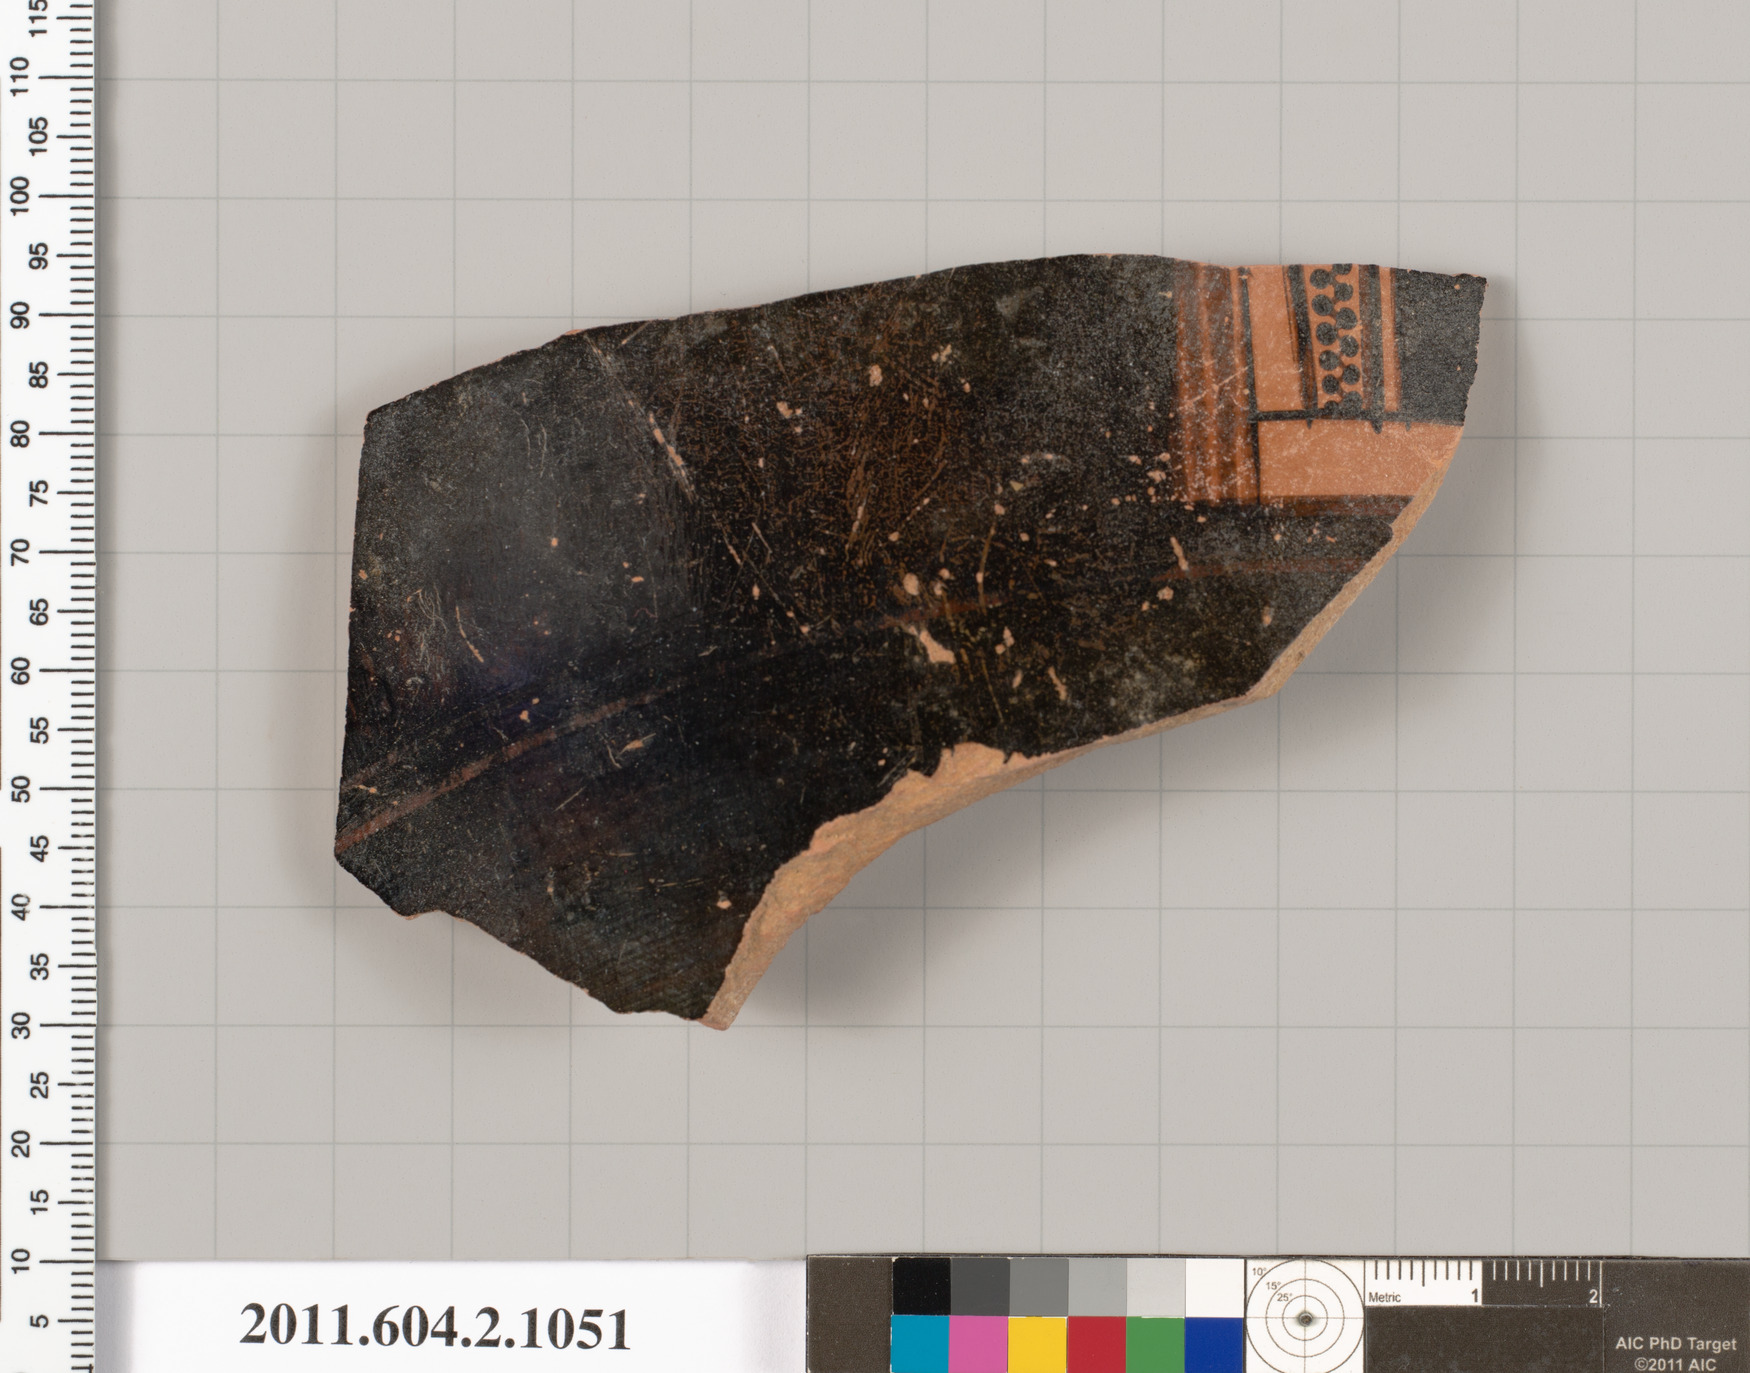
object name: pelike fragment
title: Terracotta fragment of a pelike (jar)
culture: greek, attic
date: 475-451 BCE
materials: terracotta